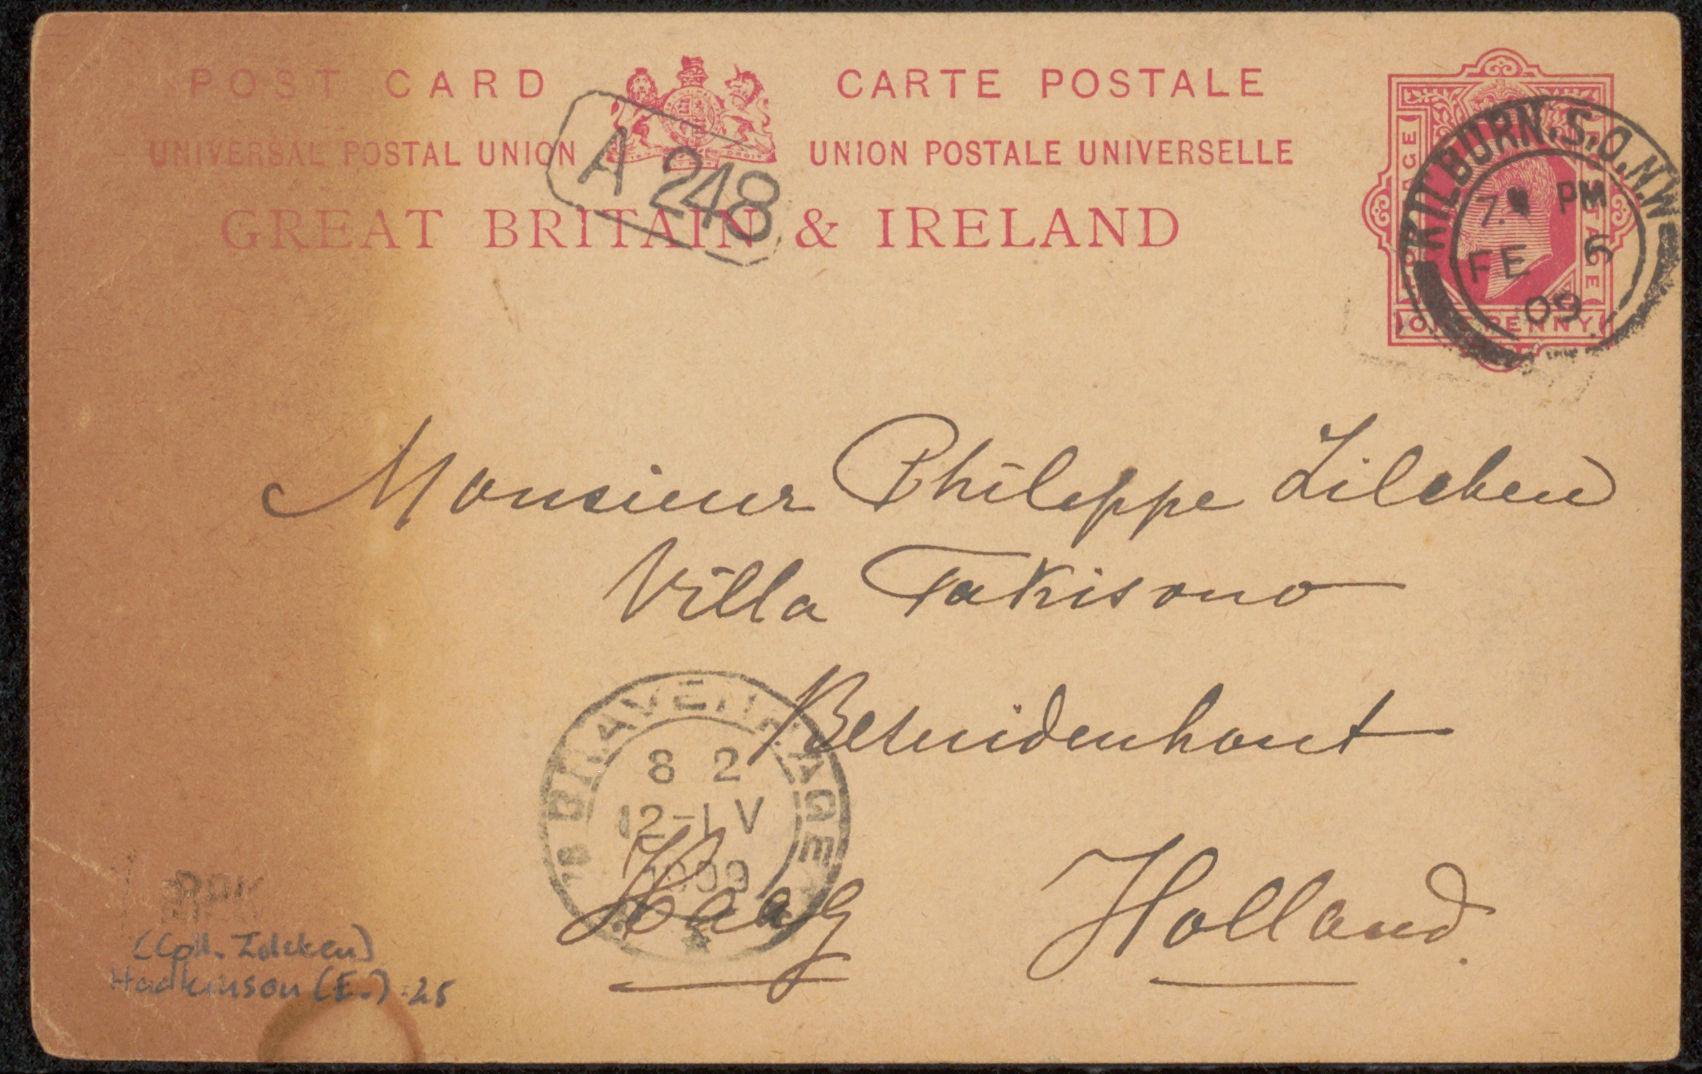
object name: postcard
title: Briefkaart aan Philip Zilcken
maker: ernestine hadkinson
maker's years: 1863-1928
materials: cardboard, ink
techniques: pen, writing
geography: kilburn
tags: flushing, designer, agathe wegerif-gravestein, the hague, draughtsman, philip zilcken, money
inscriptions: collector's mark: ‘RPK’